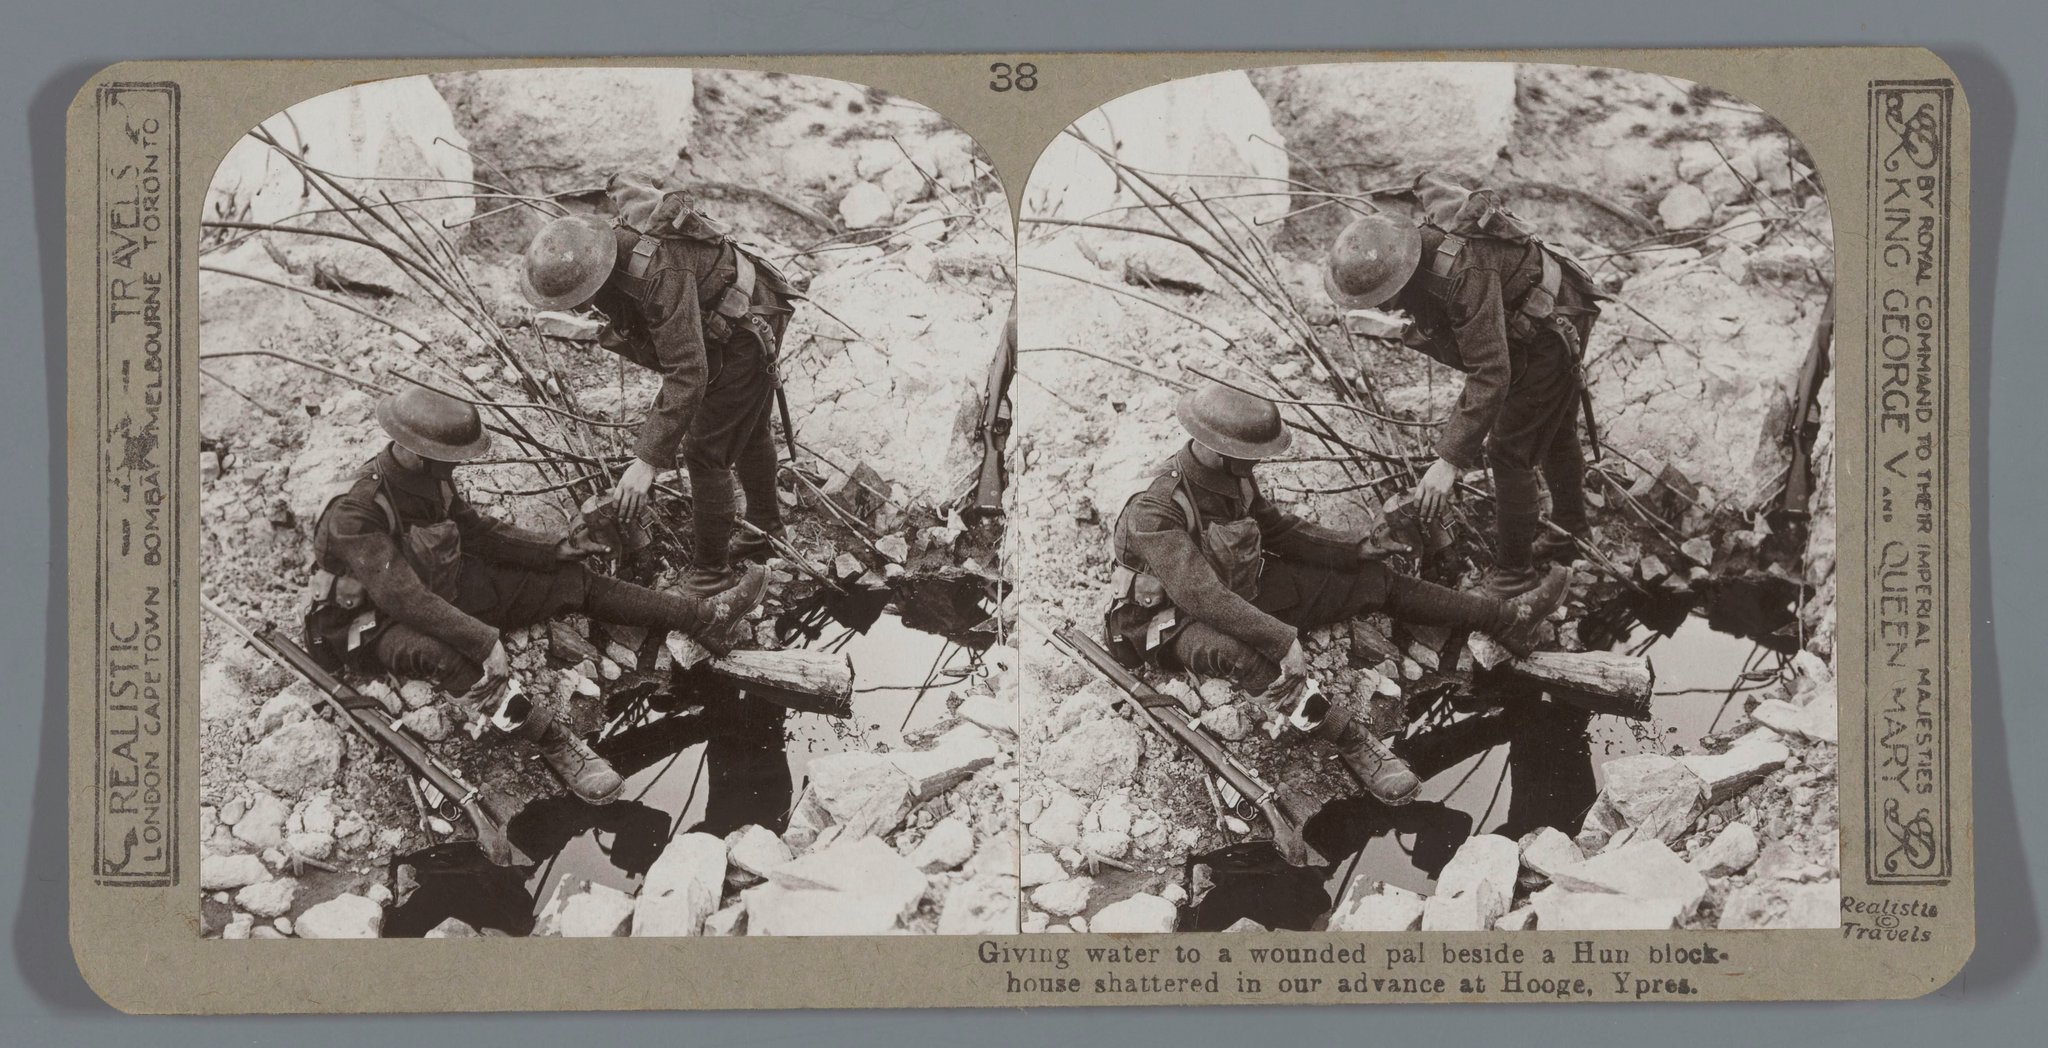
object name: stereograph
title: Giving water to a wounded pal beside a Hun blockhouse shattered in our advance at Hooge, Ypres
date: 1914-1918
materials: cardboard, photographic support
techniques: gelatin silver print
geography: ieper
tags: private soldier, medical aid and nursing of the sick and wounded on the battlefield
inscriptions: inscription: ‘By Royal command to their Imperial majesties King George V and Queen Mary’, number: ‘38’